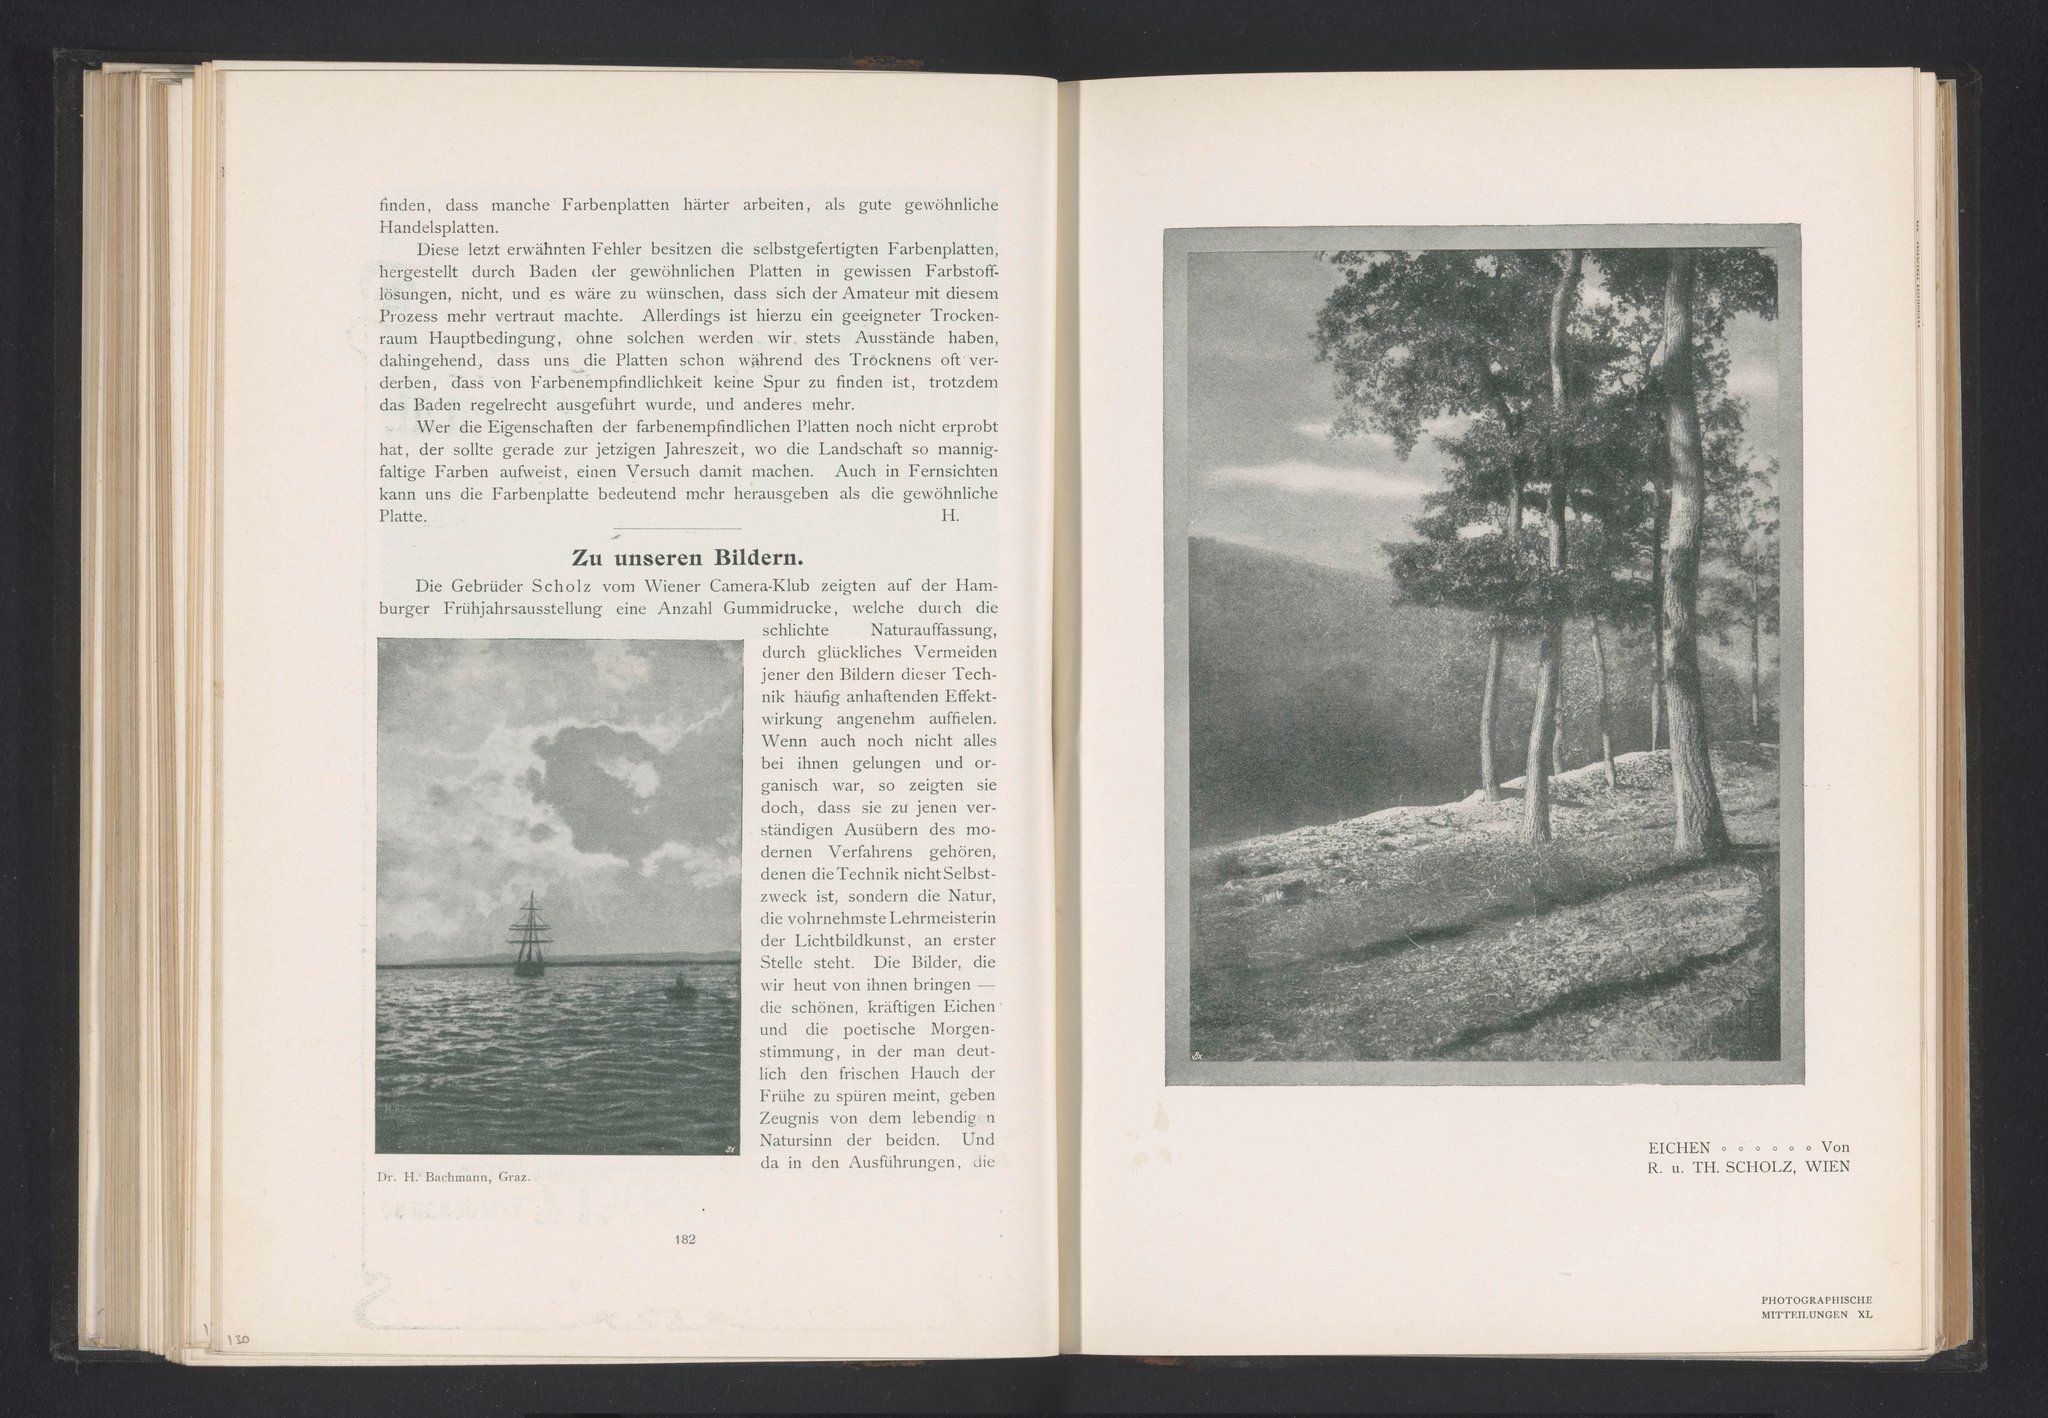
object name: photomechanical print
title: Eichen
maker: Anonymous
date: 1898-1903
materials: paper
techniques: autotype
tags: landscapes, trees: oak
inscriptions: monogram: ‘BX’